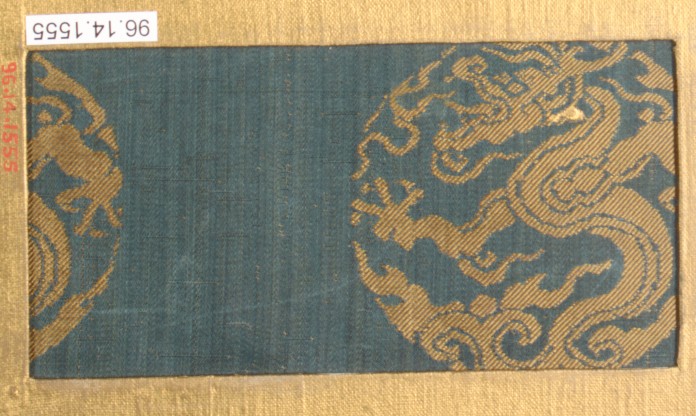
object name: piece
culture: japanese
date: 1701-1900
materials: silk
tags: dragons